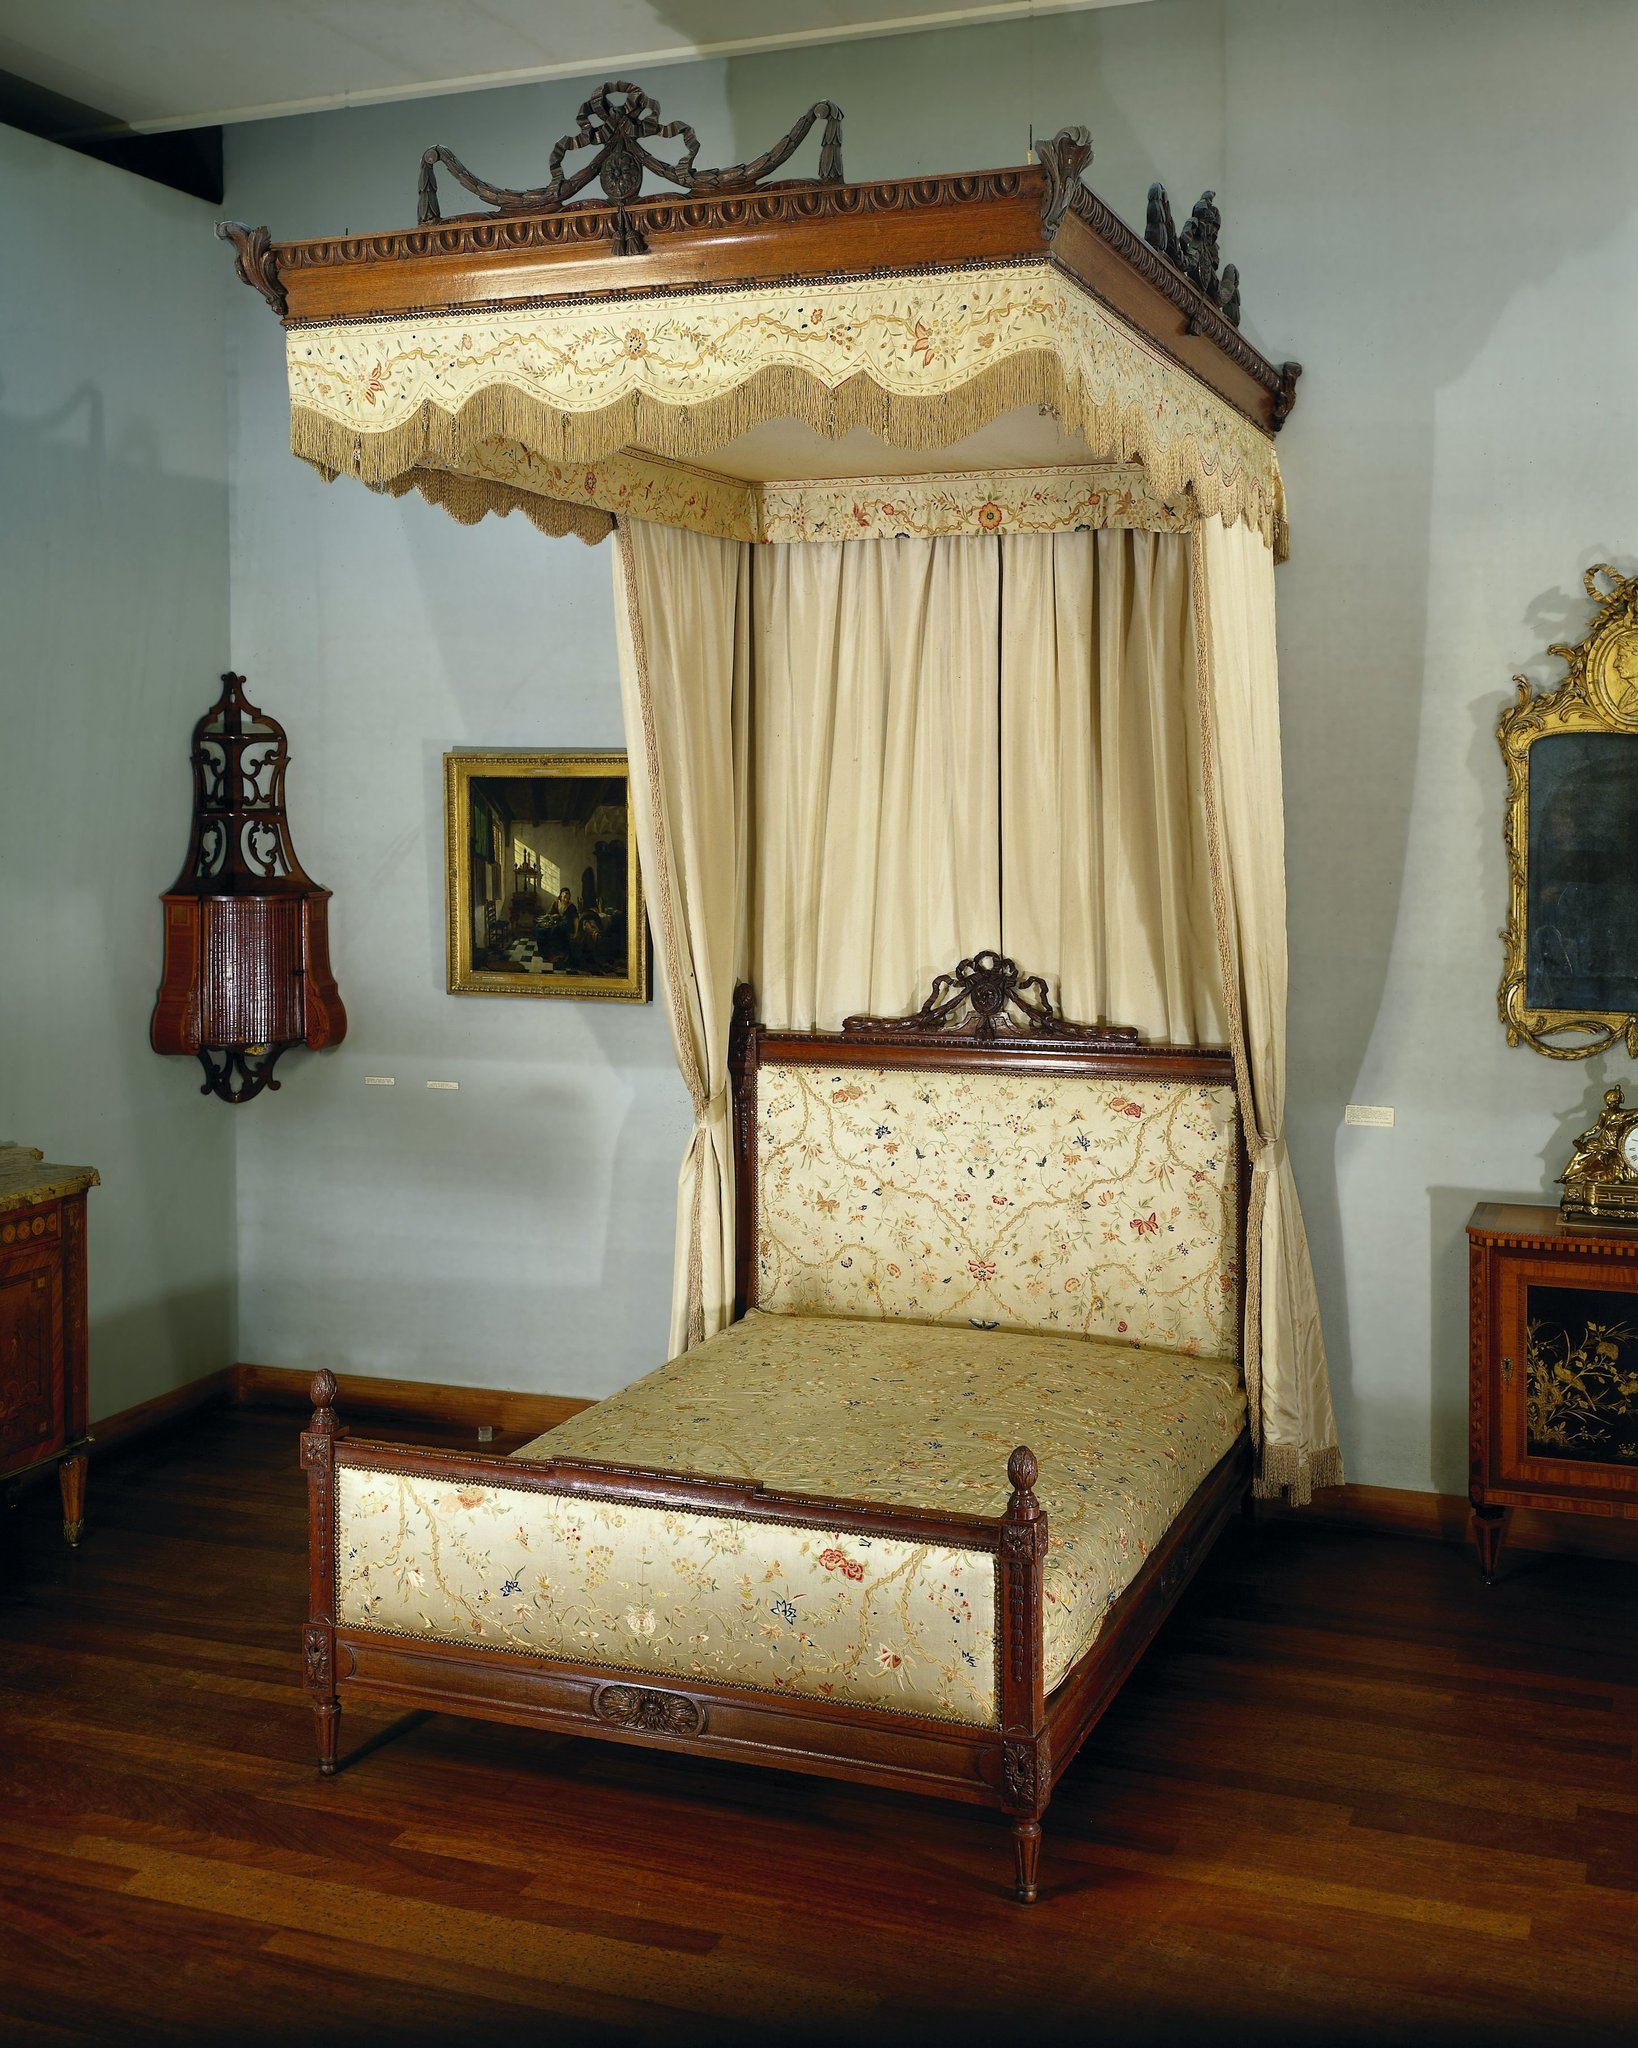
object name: bed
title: Ledikant van eikenhout, met hemel en losse gordijnen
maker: Anonymous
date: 1785-1800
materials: wood, textile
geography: northern netherlands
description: Bed. Oak. Netherlands, c. 1780 - 1800. The hangings and counterpane of embroidered satin are not original to the bed. China, late 18th century, after European patterns.